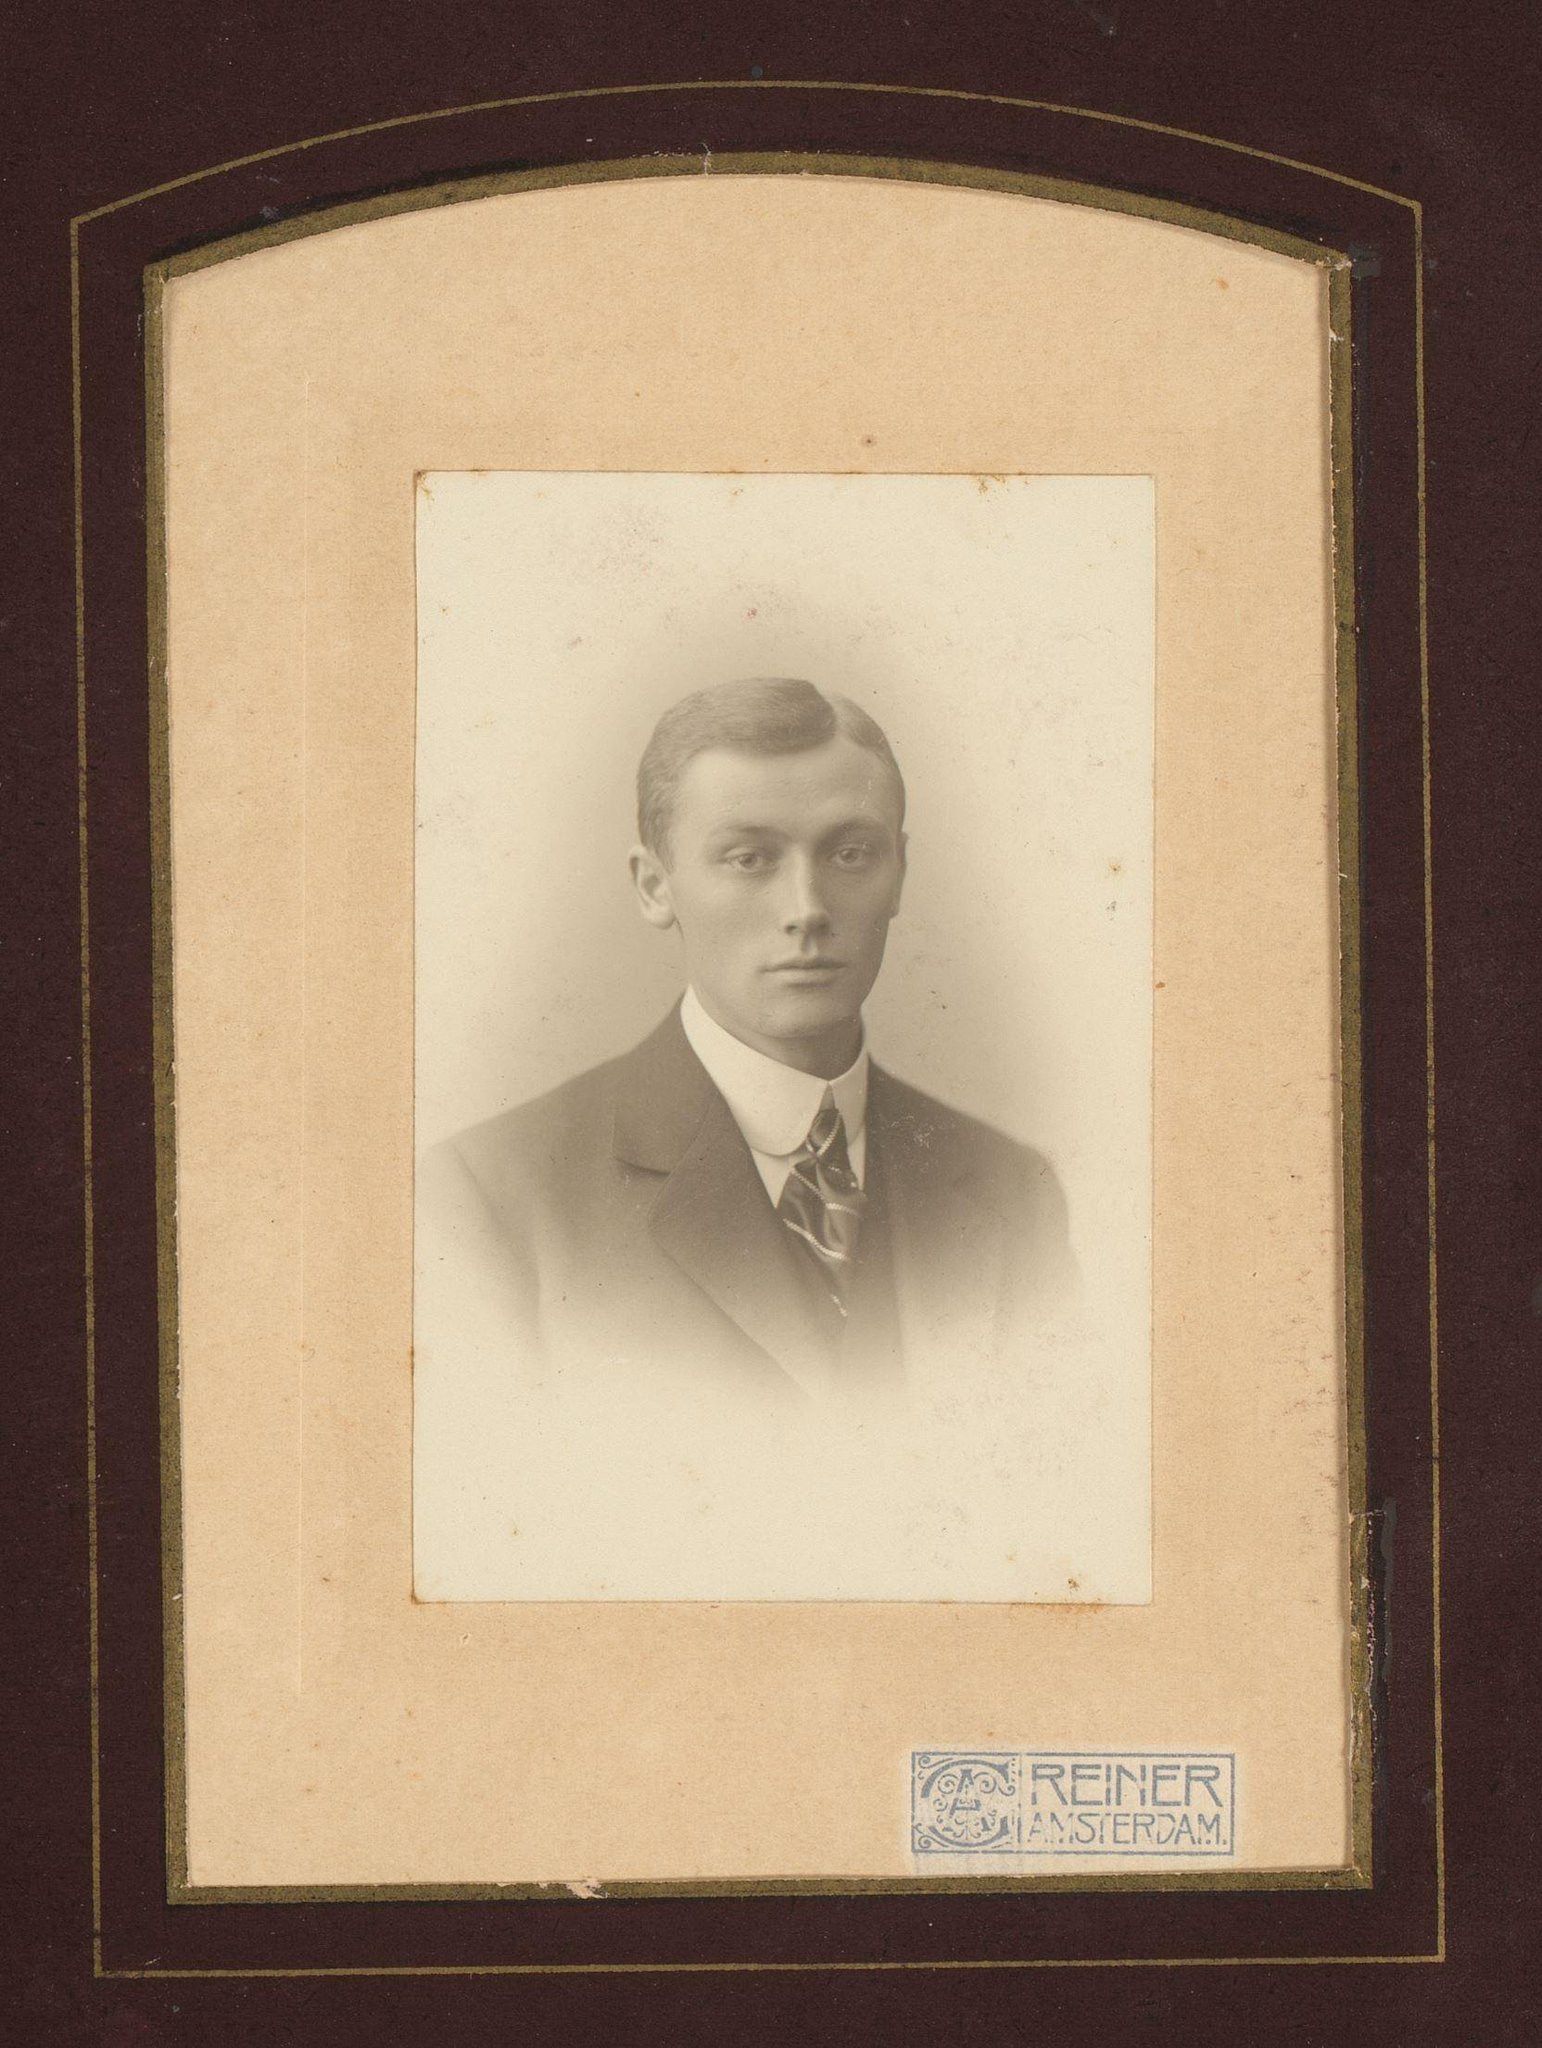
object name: photograph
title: Portret van een jonge man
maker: albert greiner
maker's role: fotograaf, fotostudio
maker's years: 1833-1890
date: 1880-1890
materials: cardboard, photographic support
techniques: collodion silver print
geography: amsterdam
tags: historical persons, youth, adolescent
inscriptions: inscription: ‘A GREINER/ AMSTERDAM’, number: ‘21147’